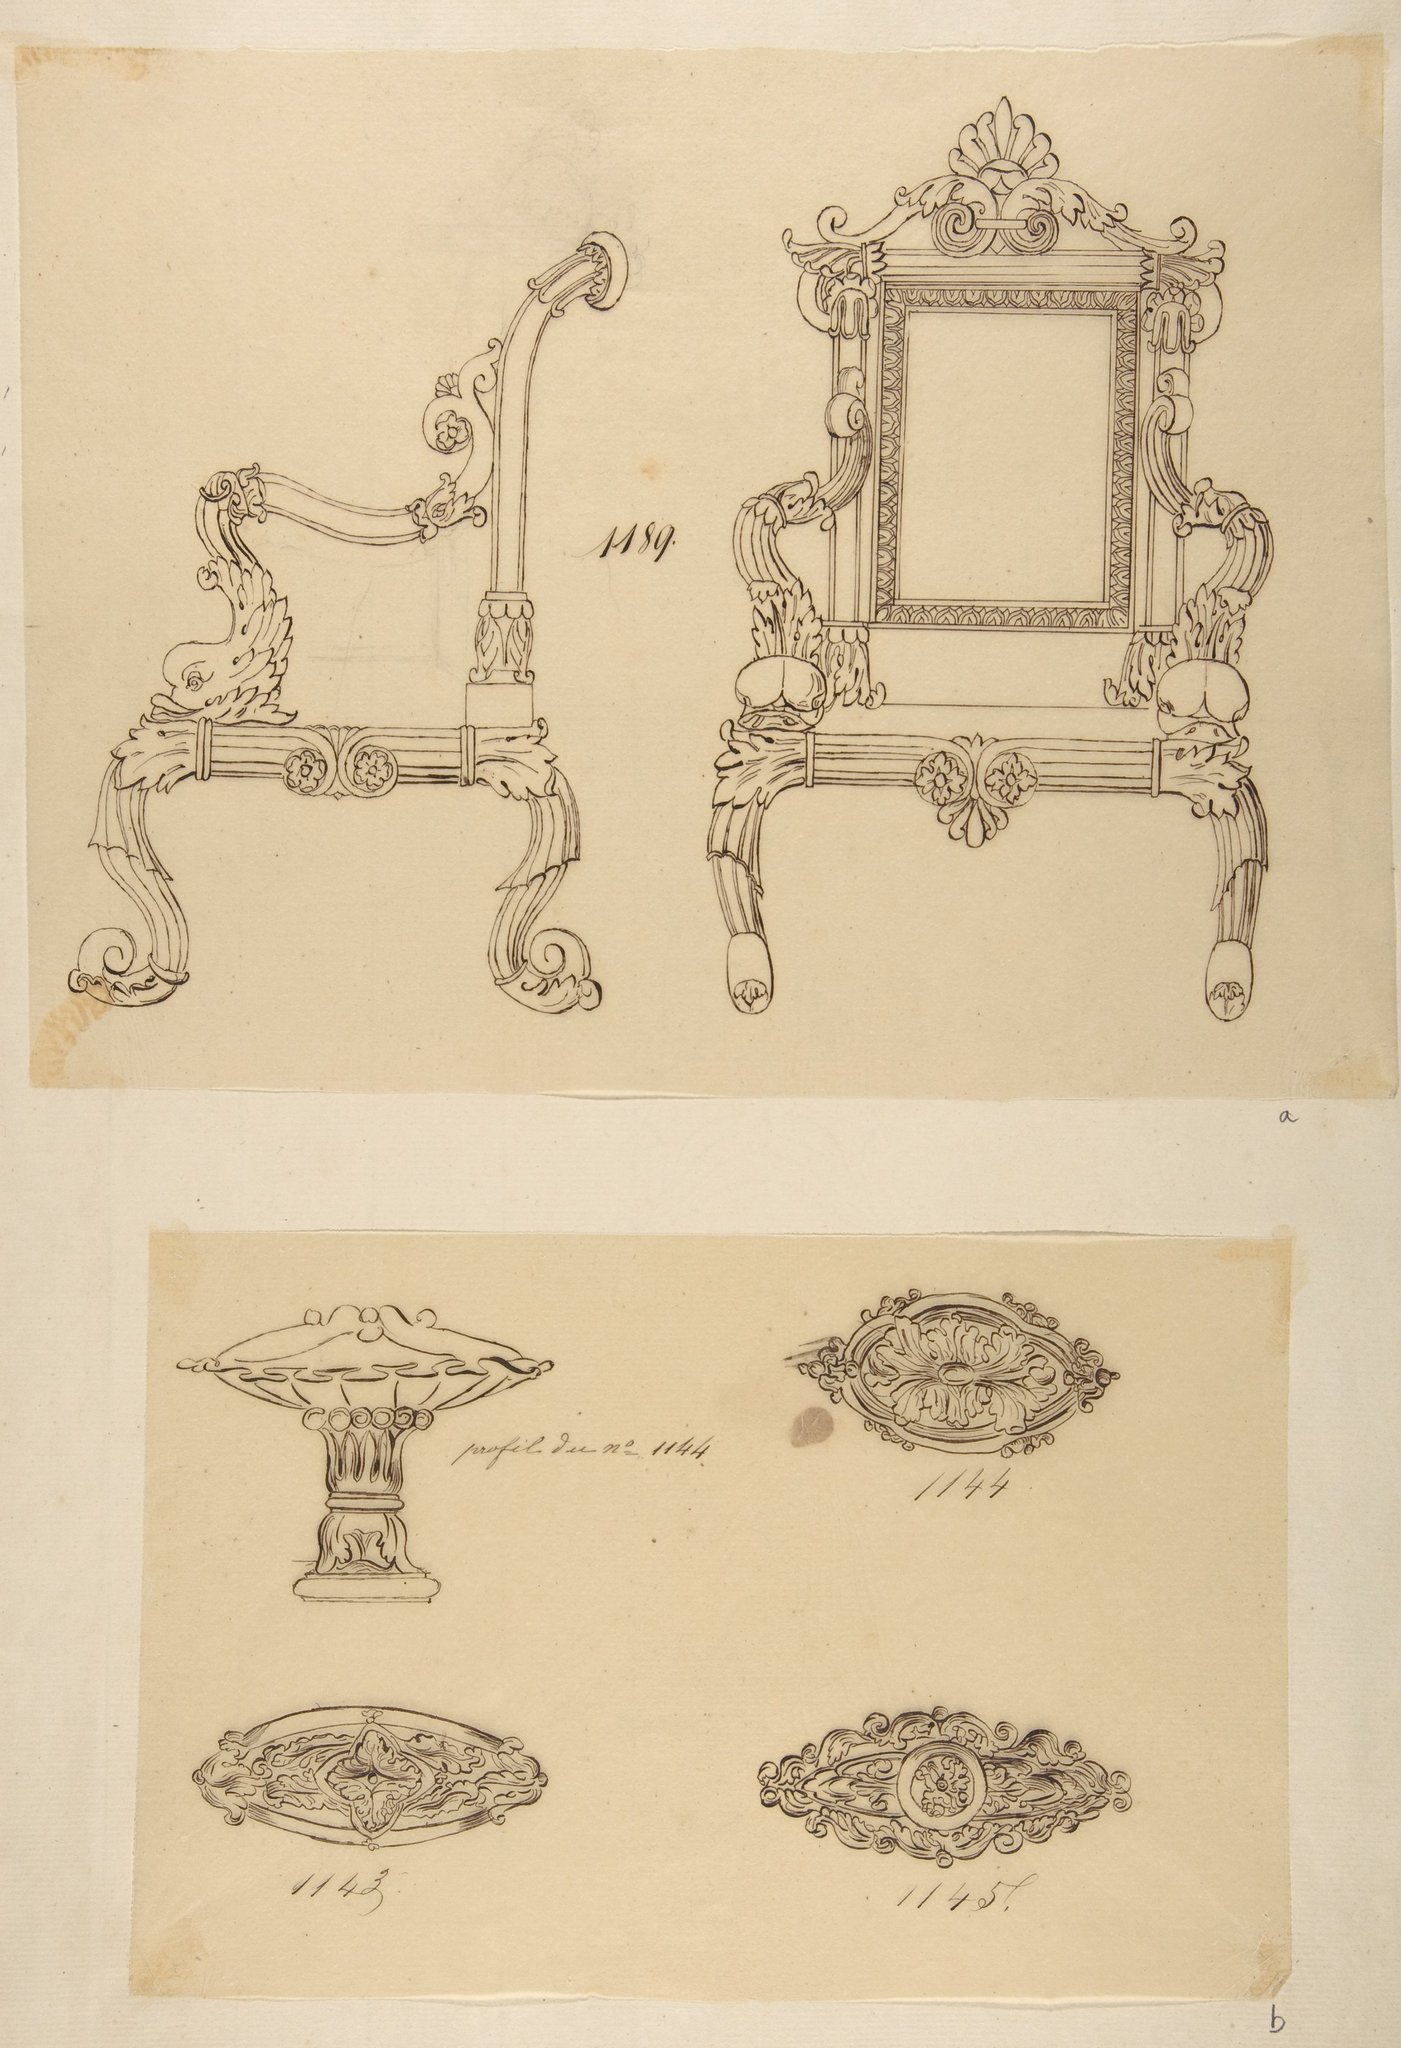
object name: drawing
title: Design for a Chair and Three Designs for Ceiling Molding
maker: anonymous, french, 19th century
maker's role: artist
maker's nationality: french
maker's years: 1800-1900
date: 1801-1900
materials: ink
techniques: pen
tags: palmettes,chairs